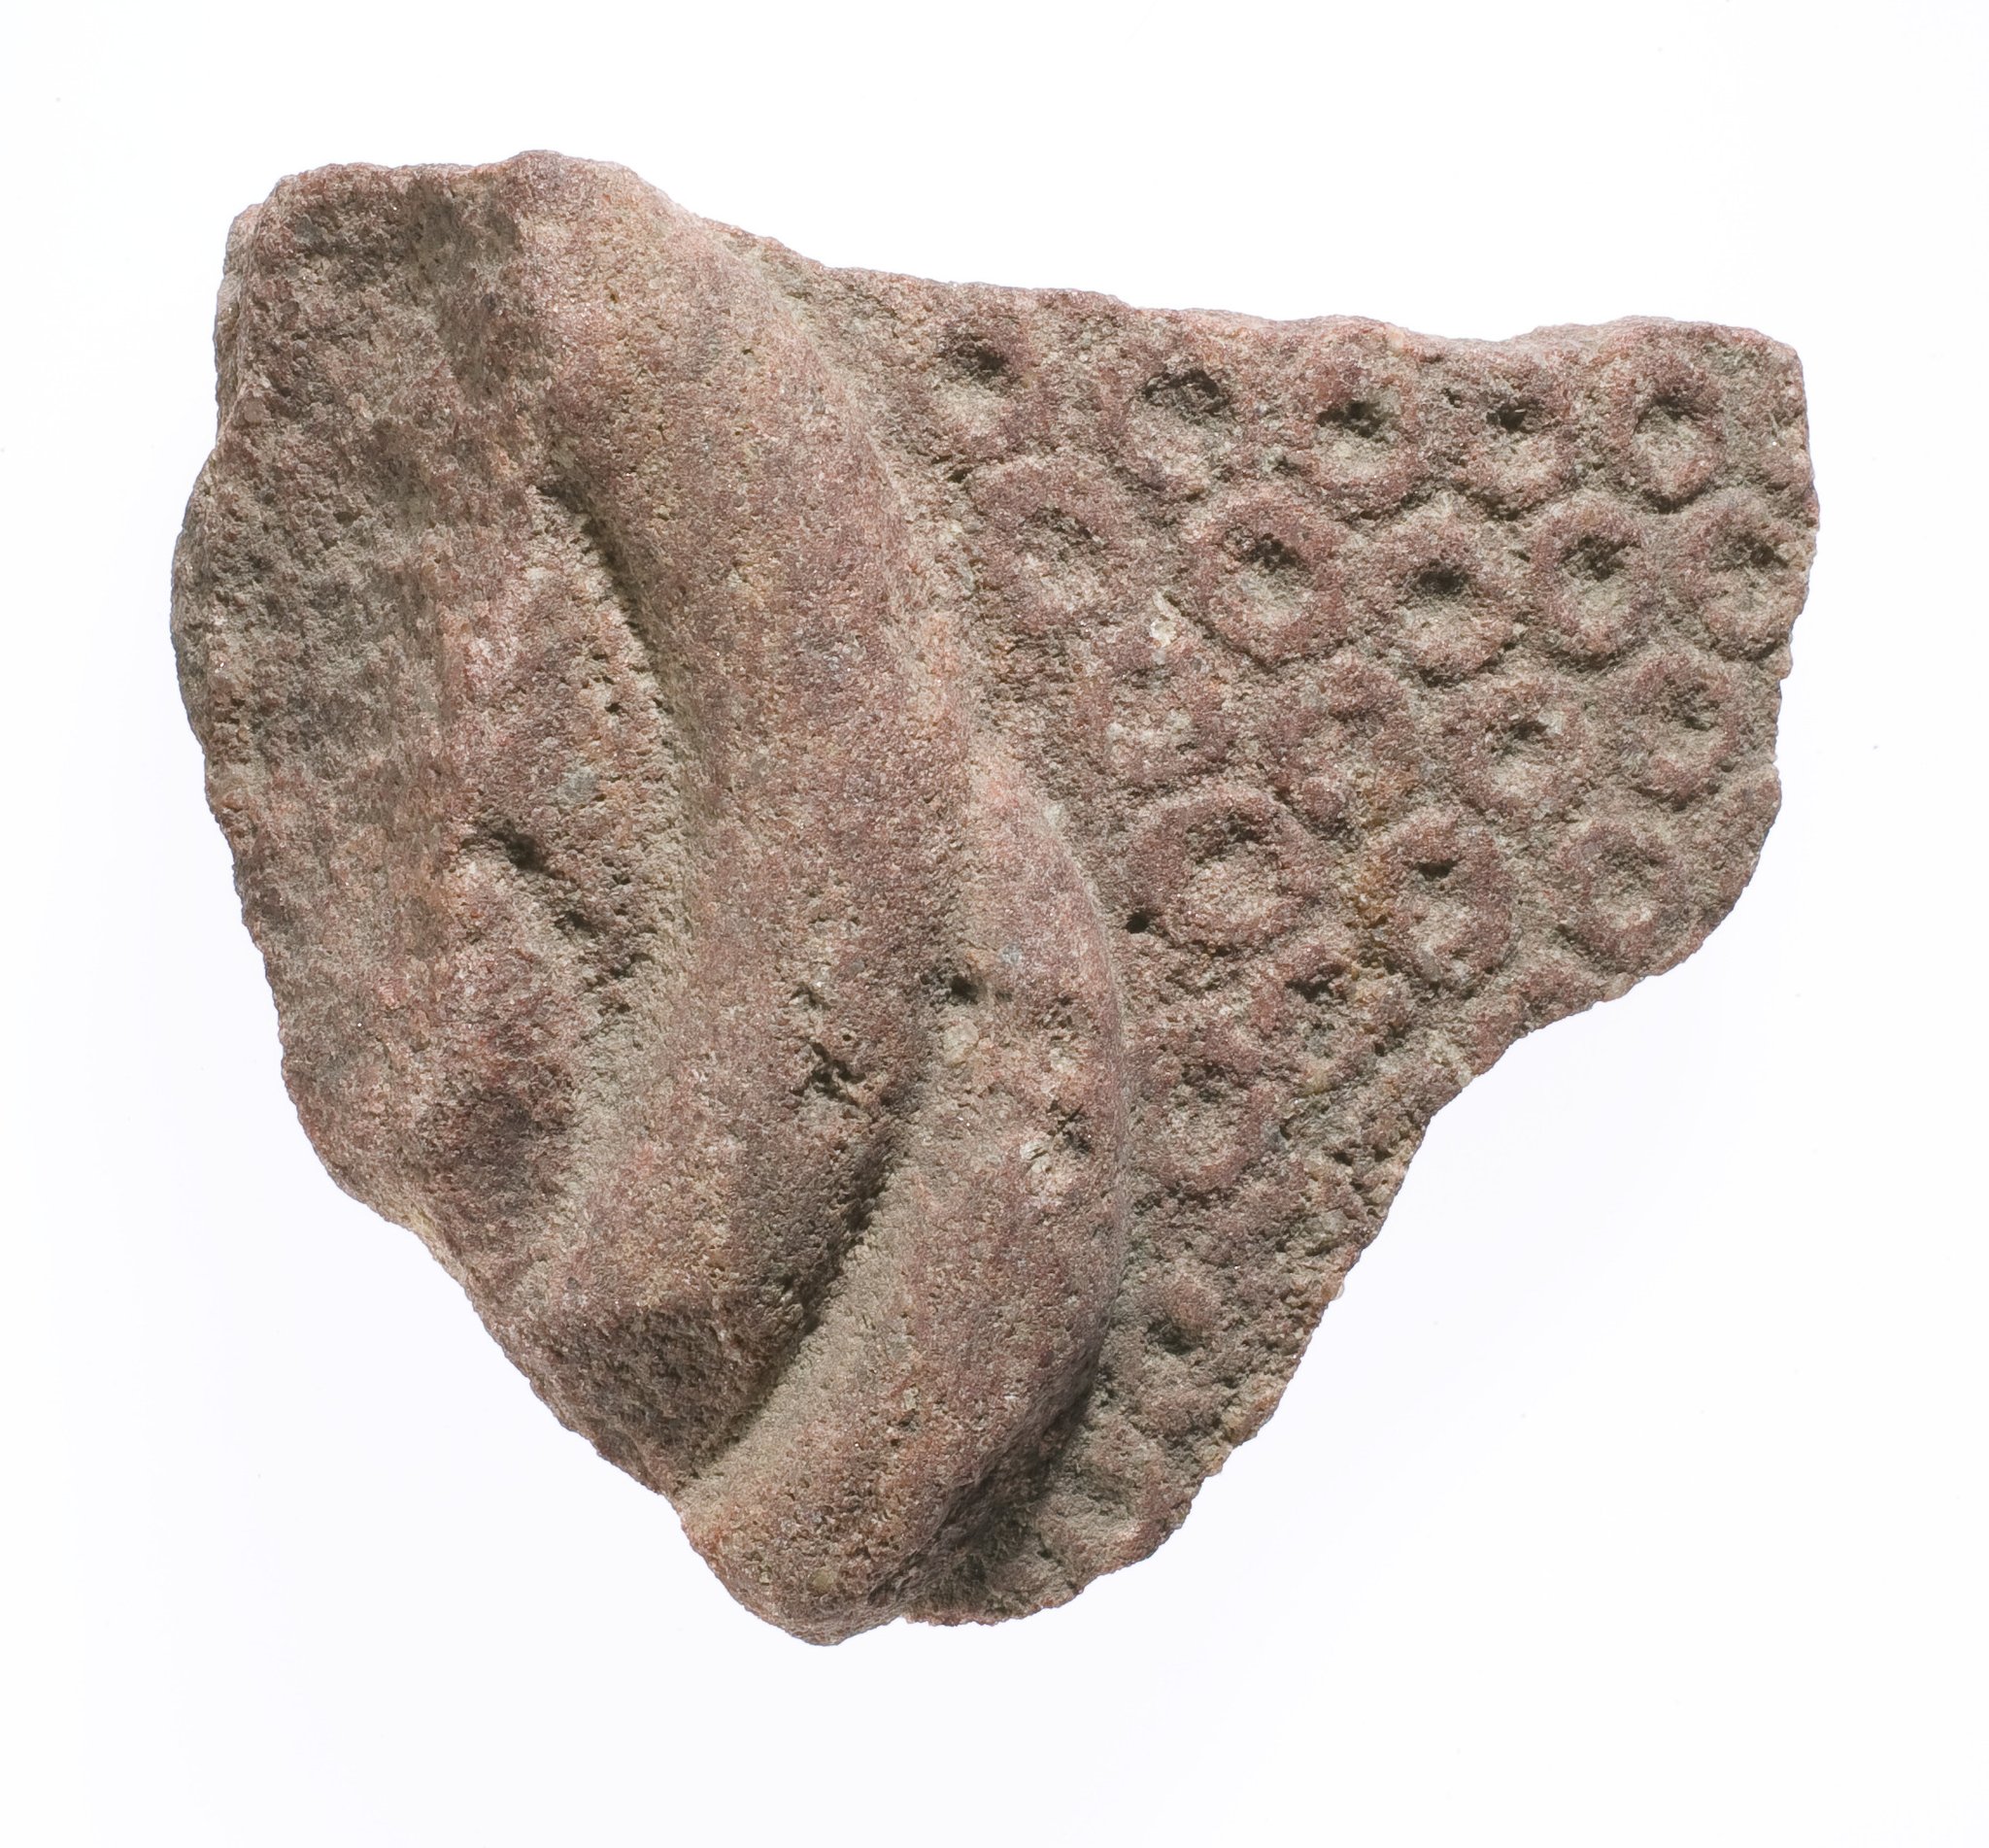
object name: crown with disk, uraeus coil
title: Crown with discs and uraeus coils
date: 1353-1336 BCE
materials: quartzite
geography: egypt